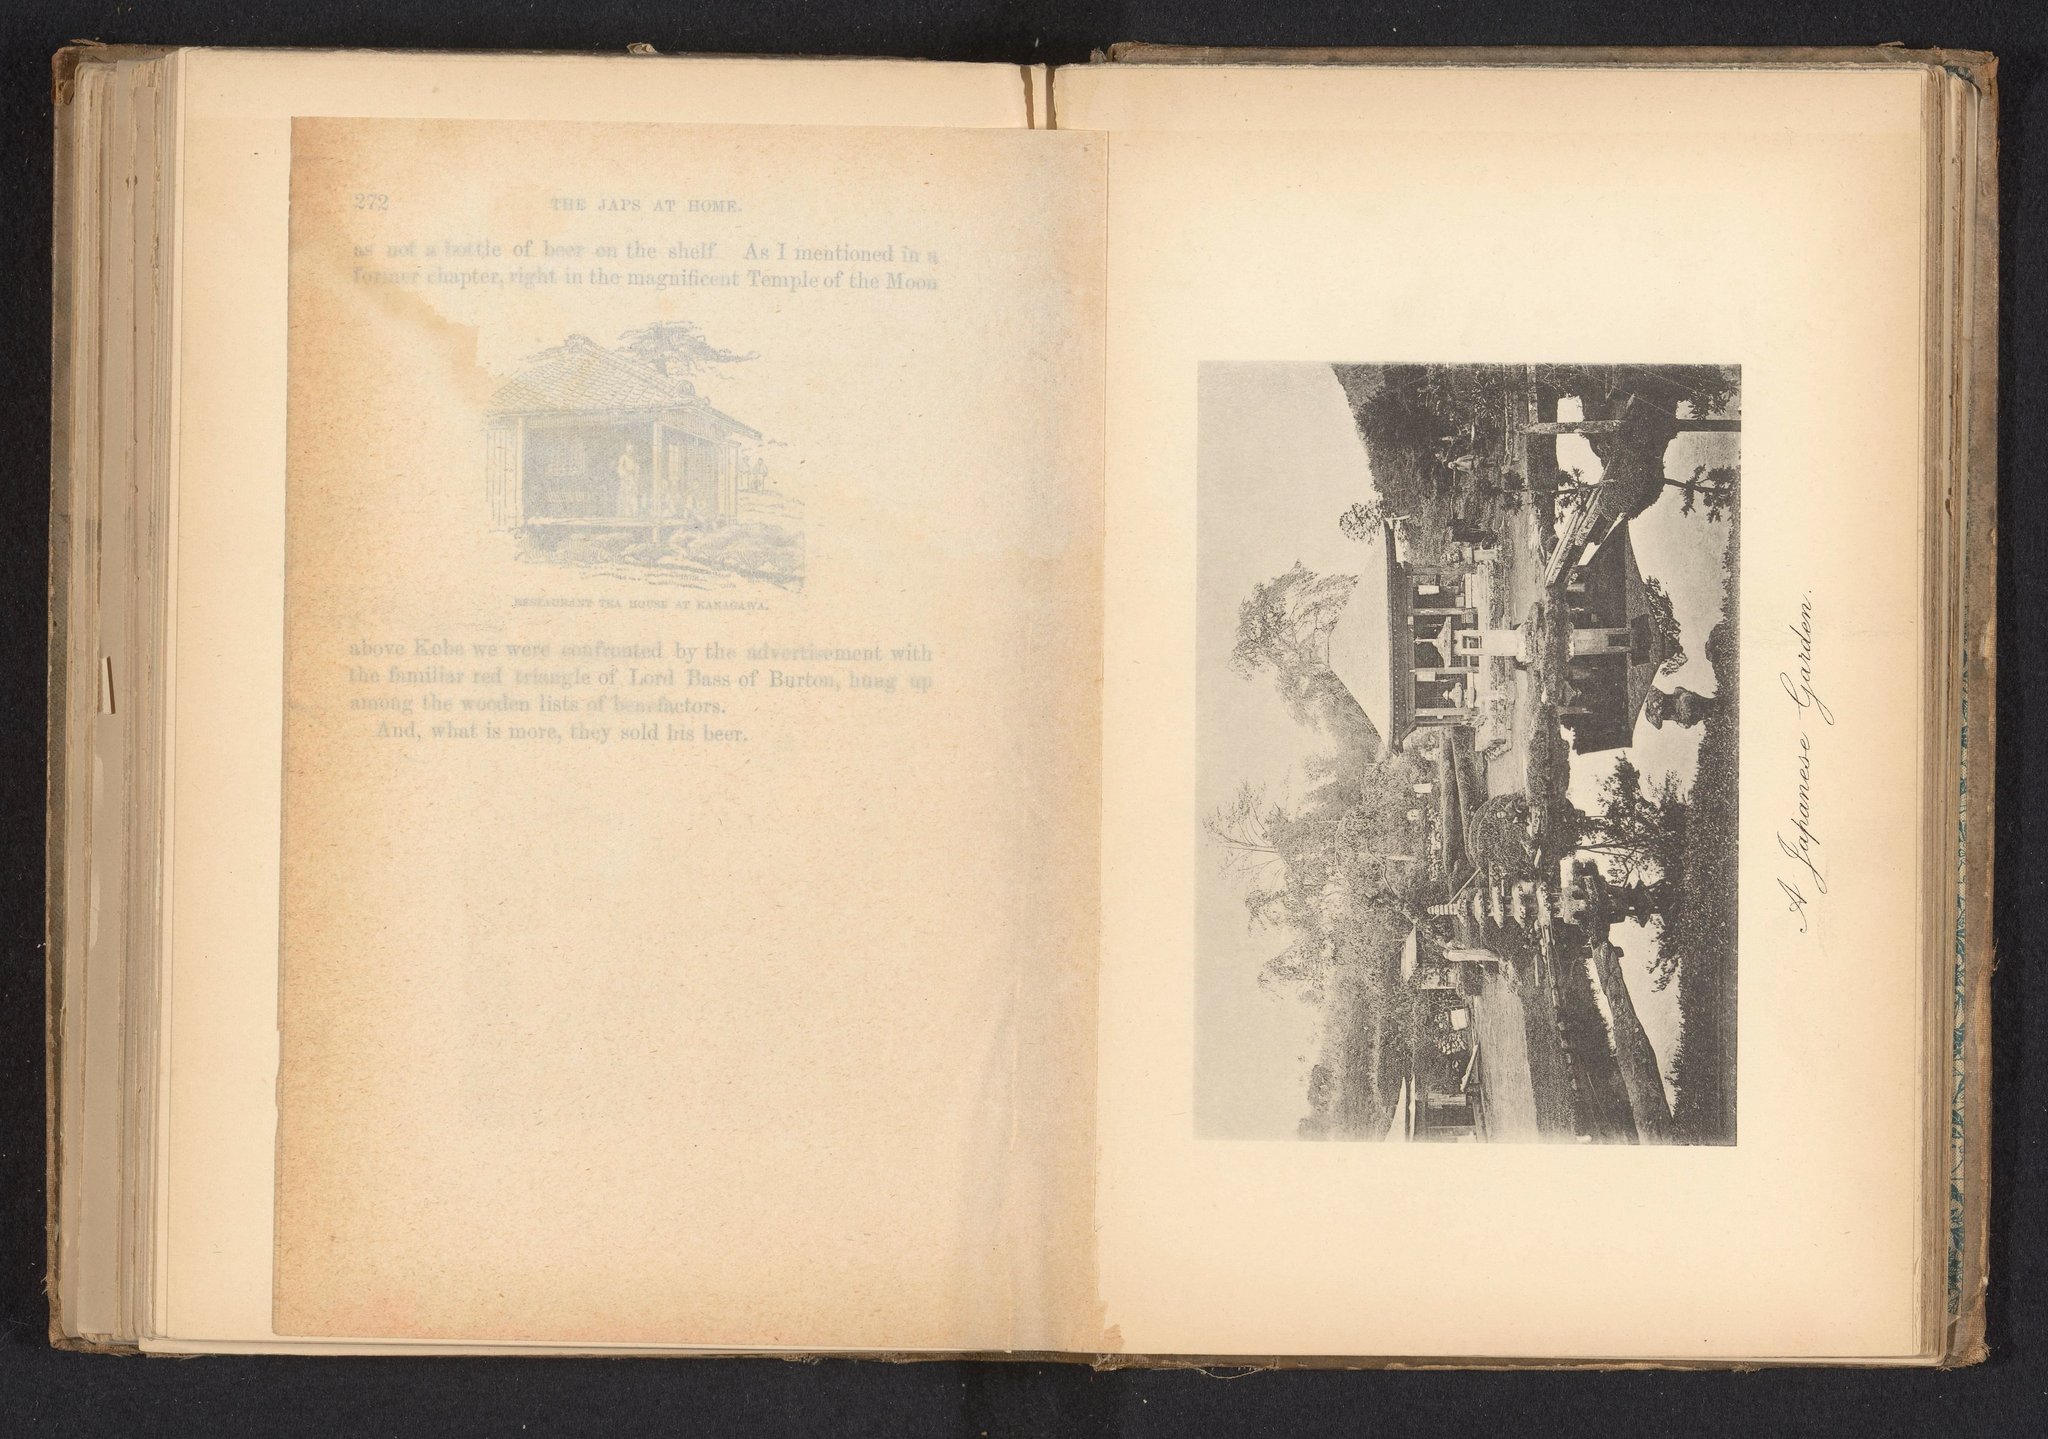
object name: page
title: Traditionele tuin in Japan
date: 1882-1892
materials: paper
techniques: photograph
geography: japan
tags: garden